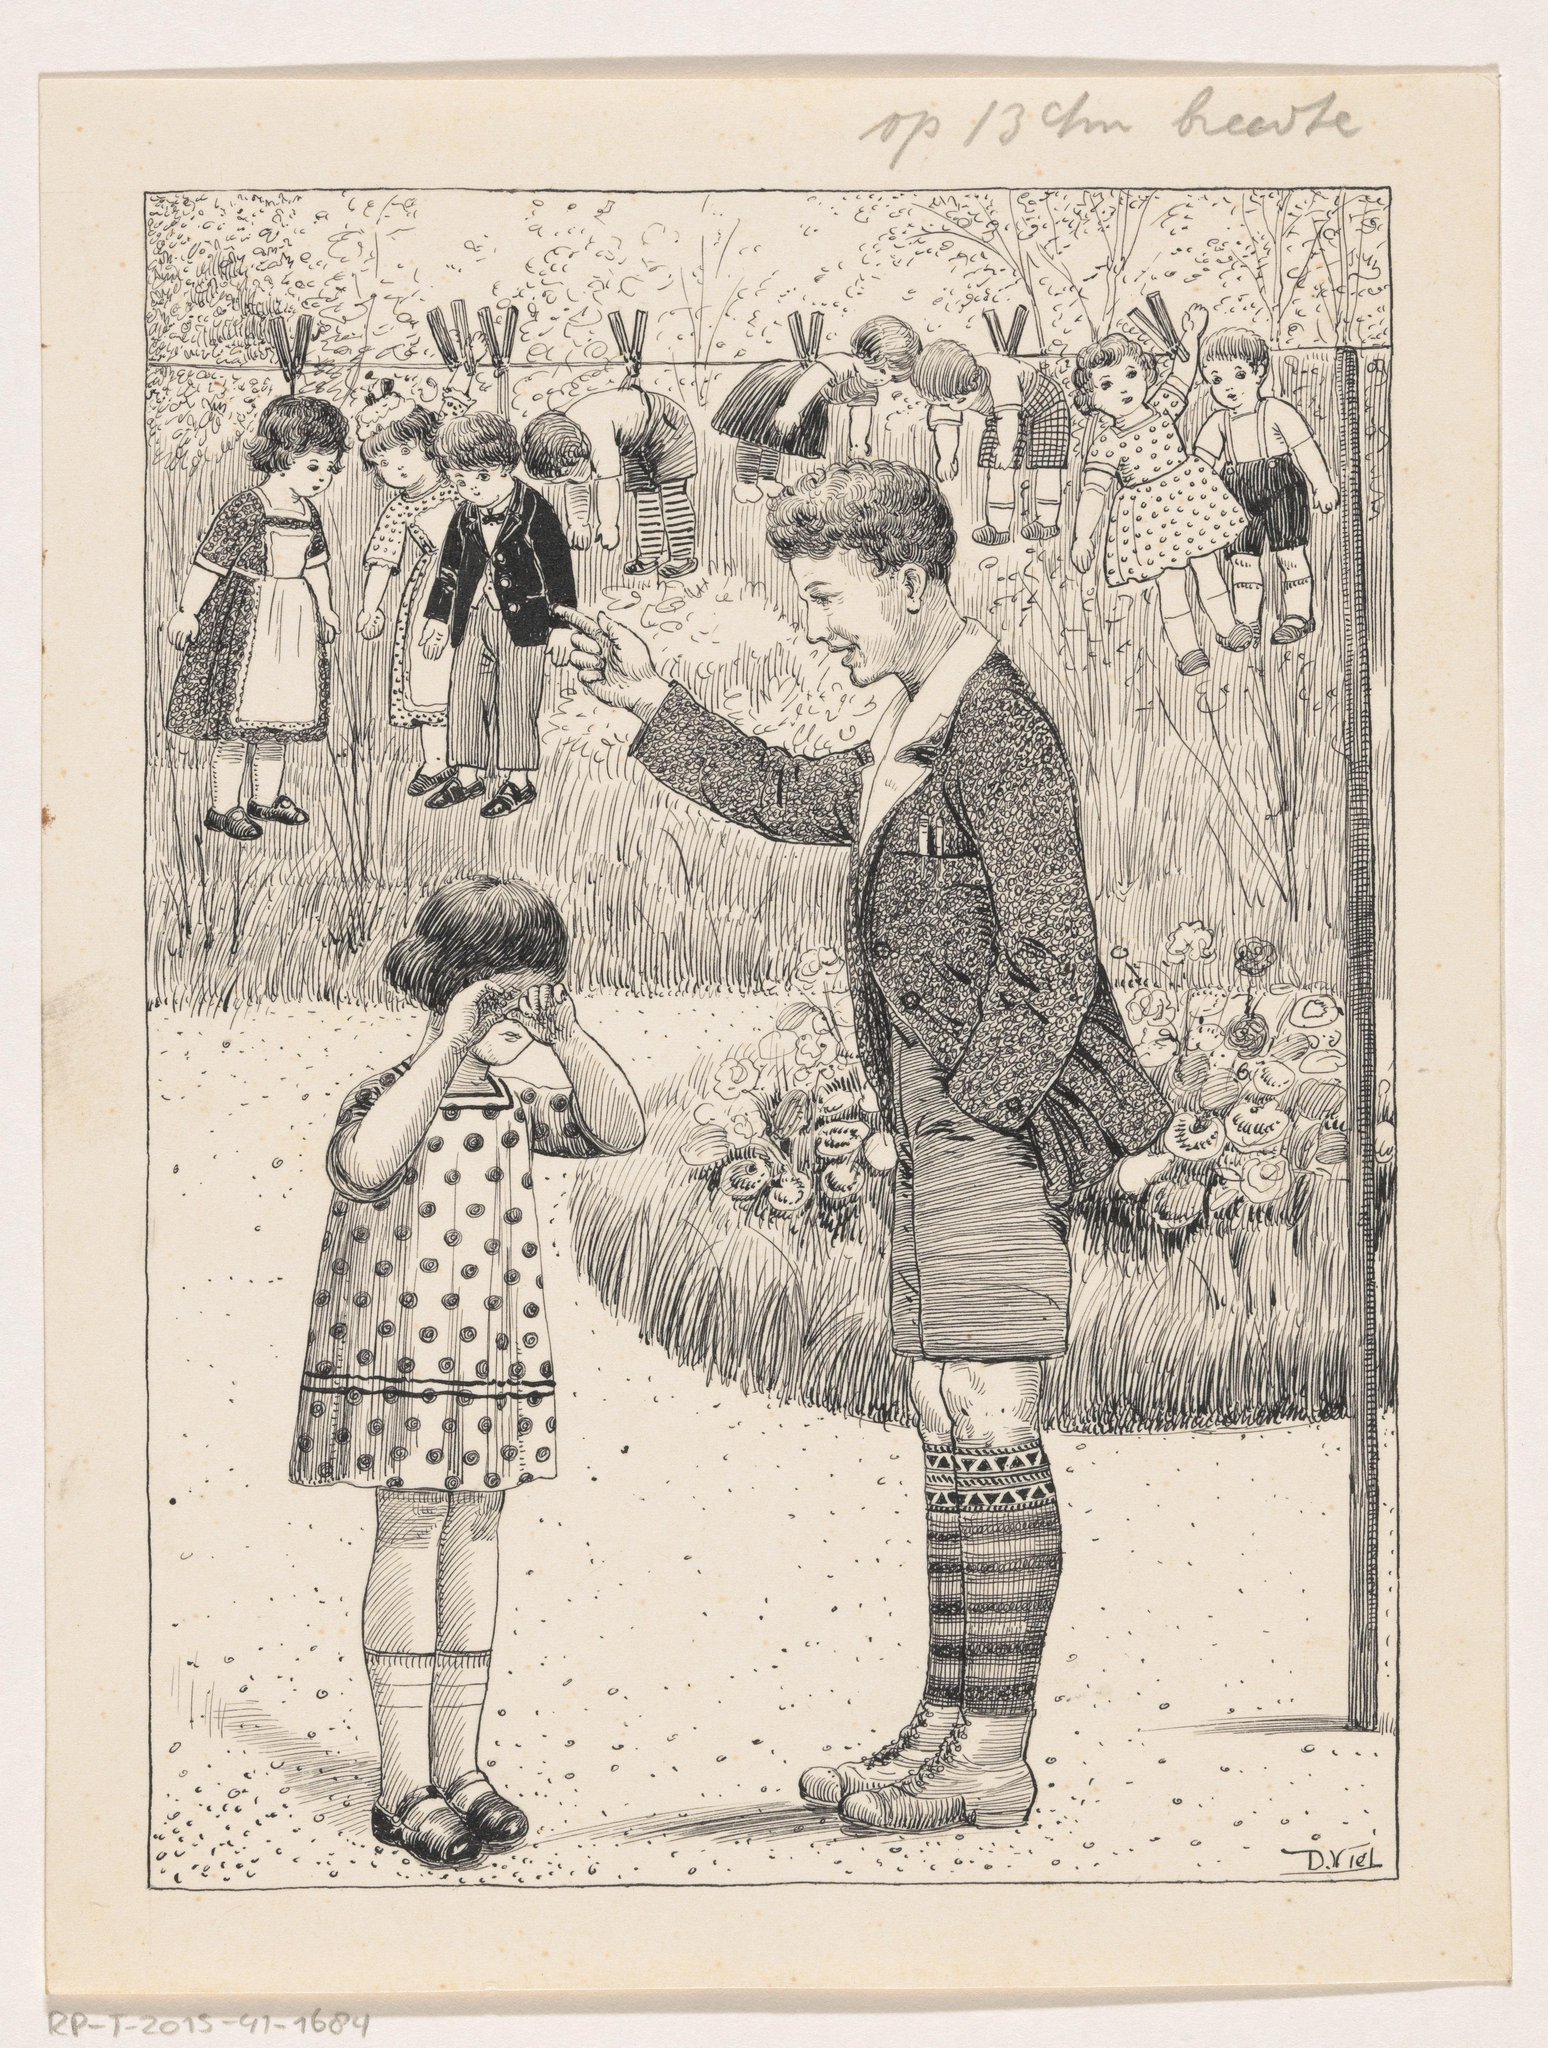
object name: drawing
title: Huilend meisje bij een waslijn vol poppen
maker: d. viel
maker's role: draughtsman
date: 1915-1935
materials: ink, paper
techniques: pen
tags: garden, (playing with) dolls, weeping, accessories and implements ~ laundering, e.g. clothes-peg, drying frame, (empty) washing line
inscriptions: collector's mark: Lugt 2228, annotation: ‘Kampeeren’, signature: ‘D. Viel’, :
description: In een tuin staat een meisje te huilen. Een oudere jongen staat naast haar en wijst omhoog. In de achtergrond is een waslijn gespannen waaraan verschillende poppen hangen te drogen.